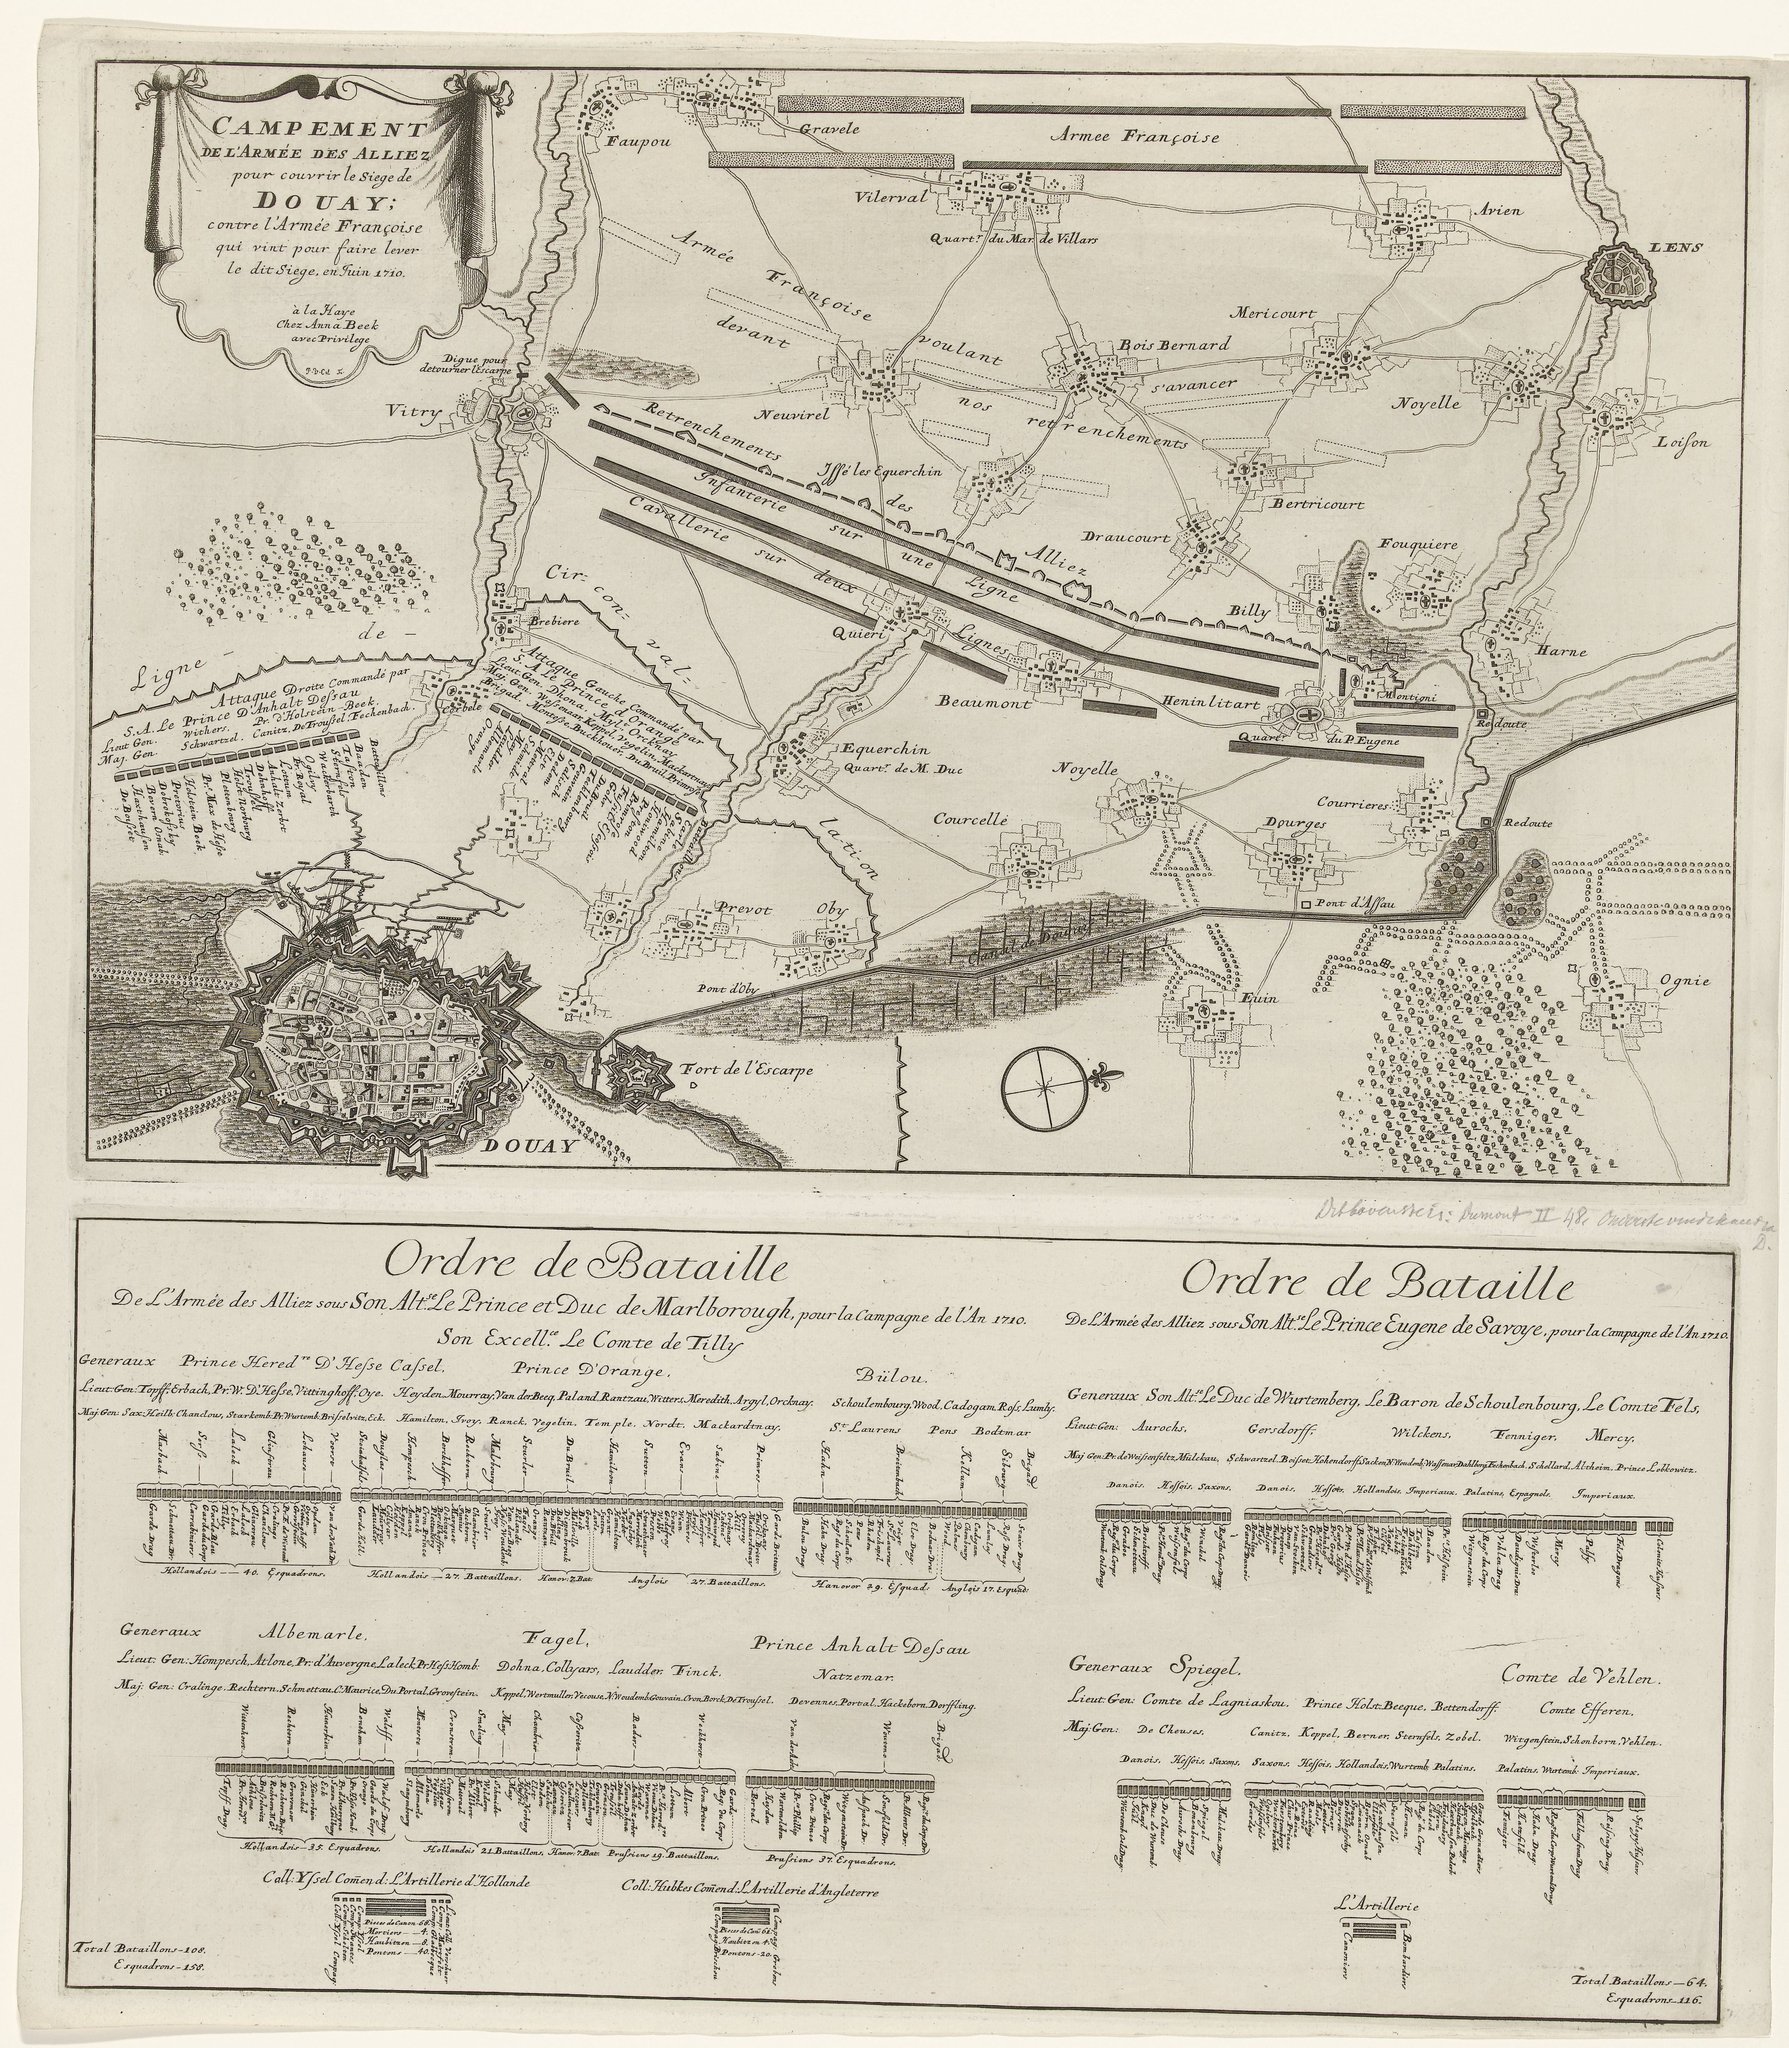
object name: print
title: Campement de l'armée des Alliez pour couvrir le siege de Douay; contre l'armée Françoise qui vint pour faire lever de dit siege, en Juin 1710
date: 1710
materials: paper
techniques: etching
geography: the hague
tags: paris, vienna, eugenius van savoye, john churchill (1e hertog van marlborough), siege, position war, maps of cities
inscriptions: collector's mark: Lugt 2228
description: In een latere staat gebruikt als illustratie in het tweede deel van : Mont, Jean du. Oorlogskundige beschryving van de veldslagen en belegeringen, der drie (...) wydvermaarde krygsoversten (...) den Prins Eugenius van Savoye, den (...) Hertog van Marlborough, en den Prins van Oranje en Nassau-Vriesland, in de editie van 1729; zie FMH 3032/II/43.